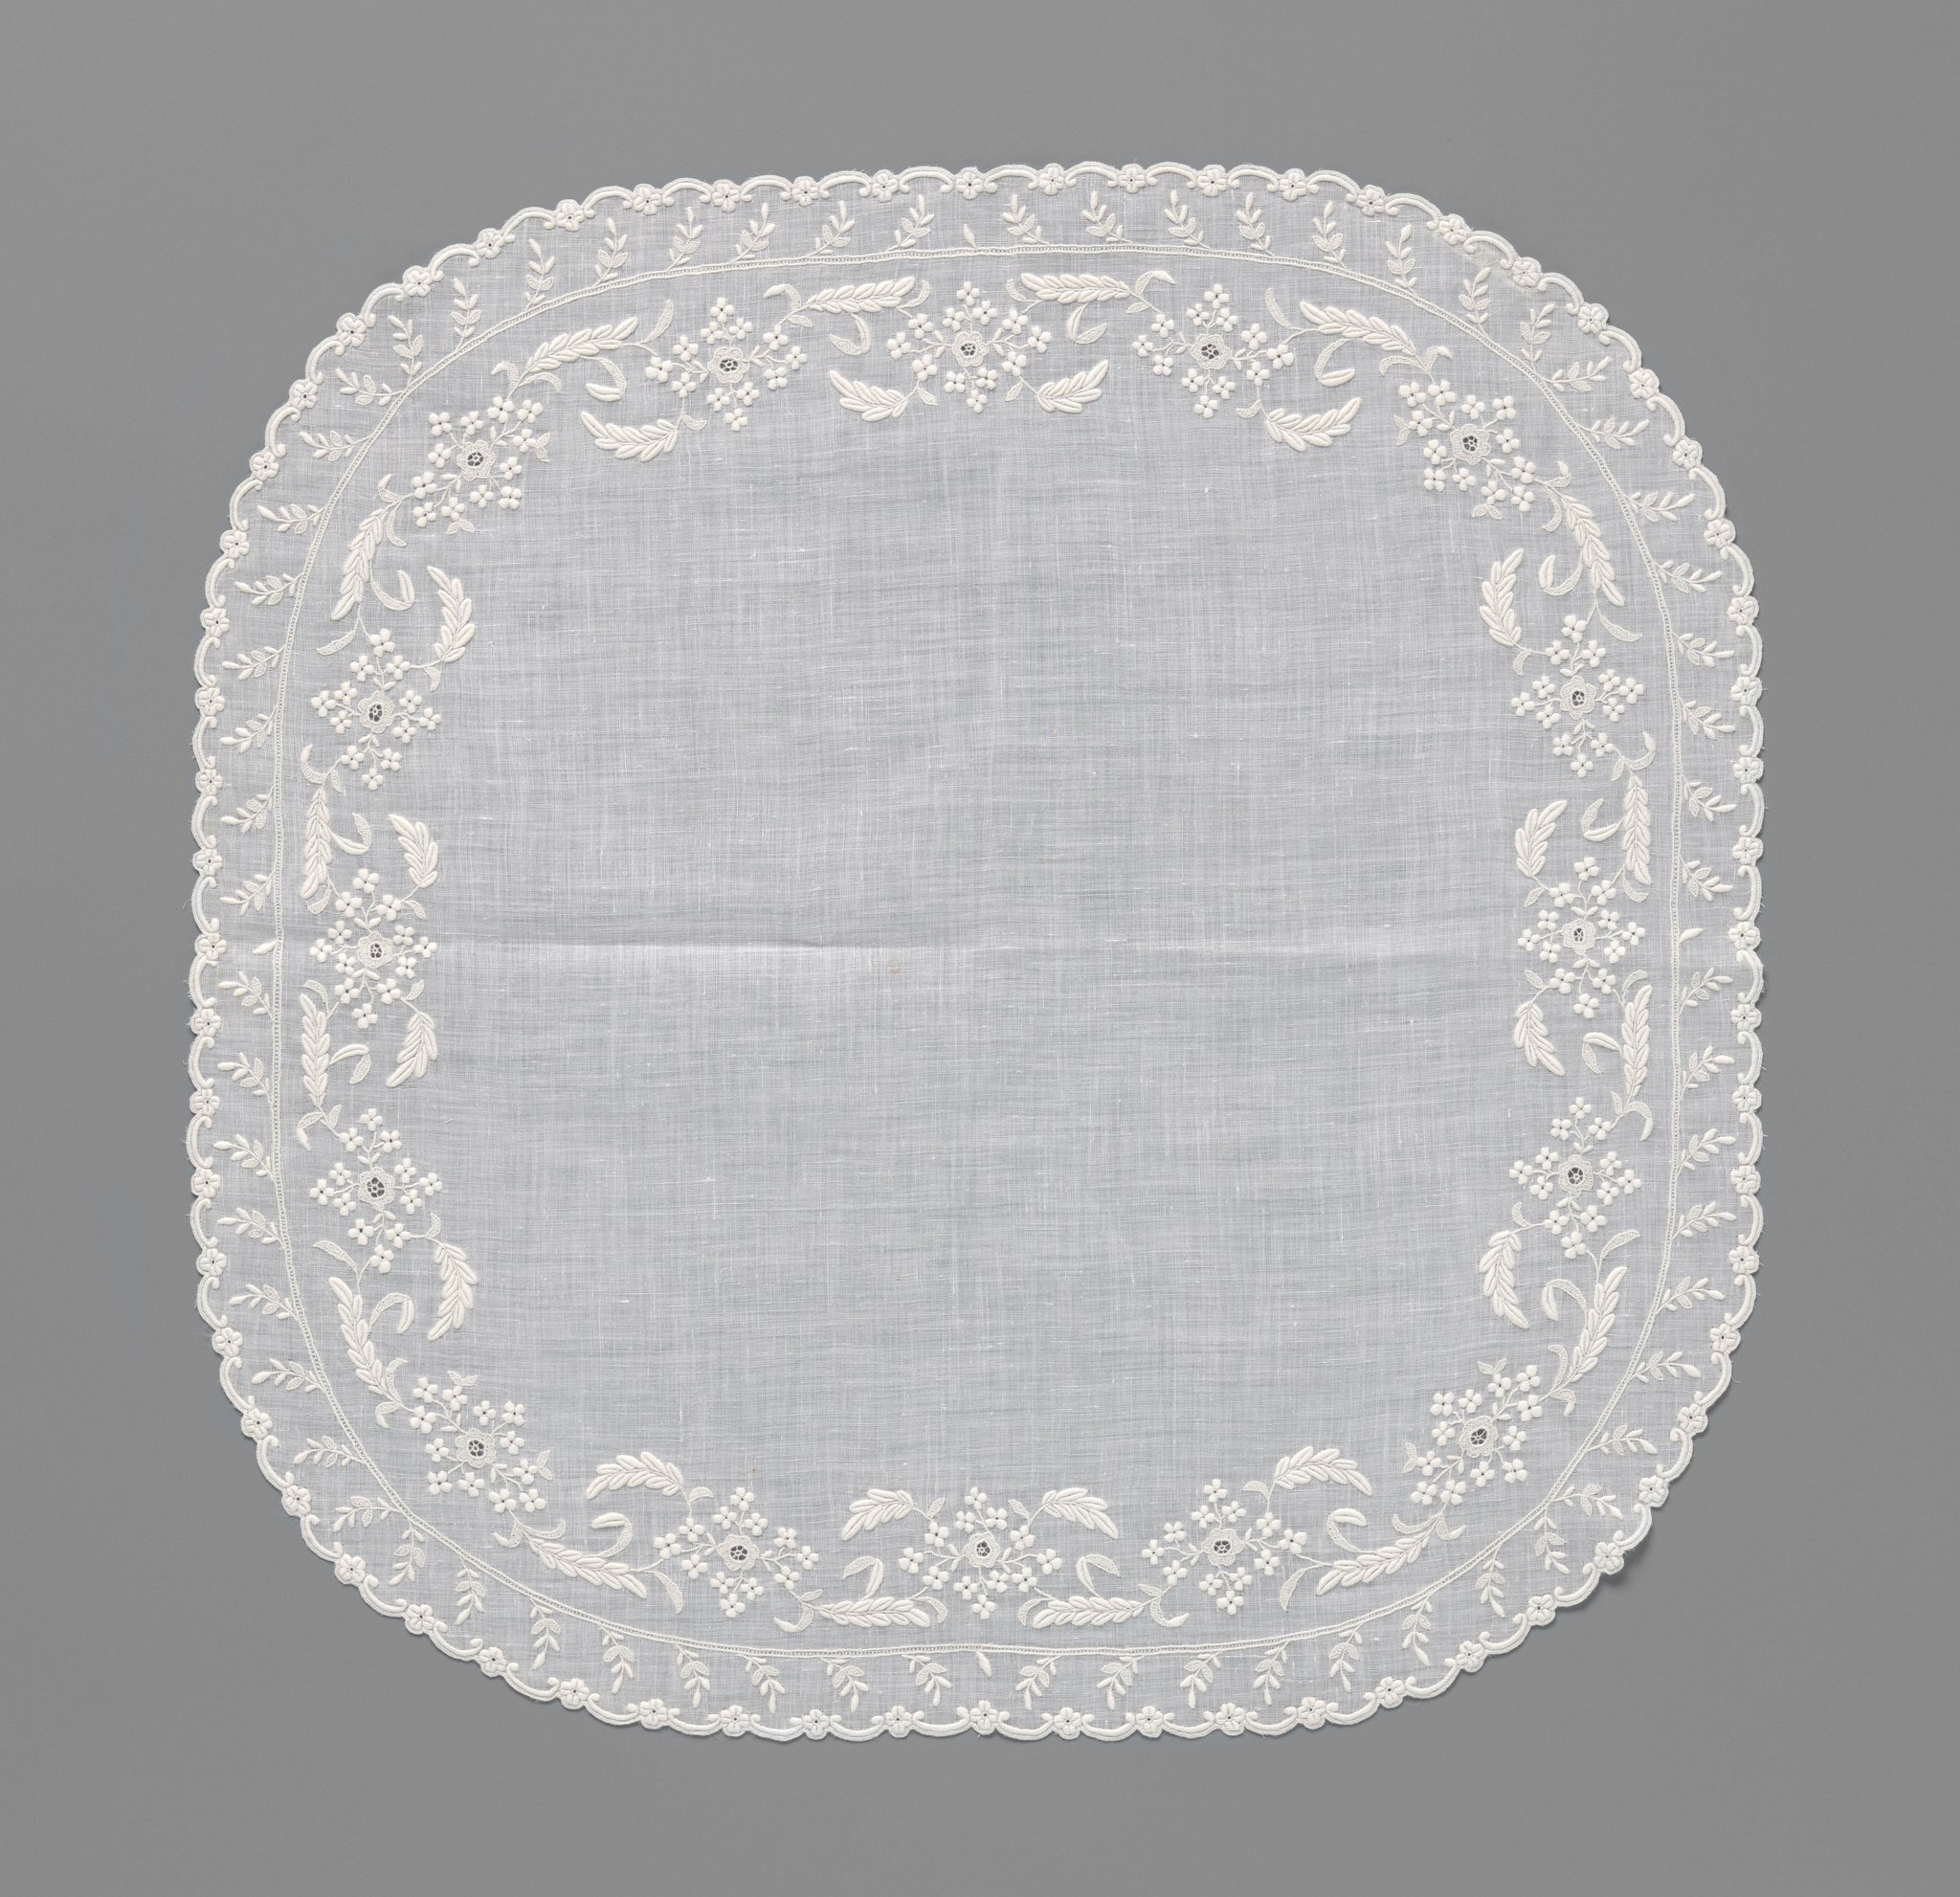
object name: clothing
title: Zakdoek van batist met rondom een driedubbele rand borduurwerk met vergeet-mij-nietjes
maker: Anonymous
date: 1850-1860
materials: textile, linen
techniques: embroidered, weave, embroidery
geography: switzerland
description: Zakdoek van batist met rondom een driedubbele rand borduurwerk: witwerk. Vierkant model met sterk afgeronde hoeken. Rondom loopt een vlakke schulpenrand met kleine afgeronde schulpjes langs een aaneenschakeling van geborduurde liggende c-voluutjes en vergeet-mij-nietjes. De volgende rand borduurwerk bestaat uit een doorgaande rechte lijn, waaraan boven elk schulpje een schuin takje met fijne blaadjes hangt. Het zich herhalende borduurpatroon langs de binnenste rand bestaat uit een rozetbloempje met open bloemhart, waar in een ruitvorm een tros vergeet-mij-nietjes omheen staat. Tussen de opeenvolgende ruitvormige trossen lange gevederde bladeren.